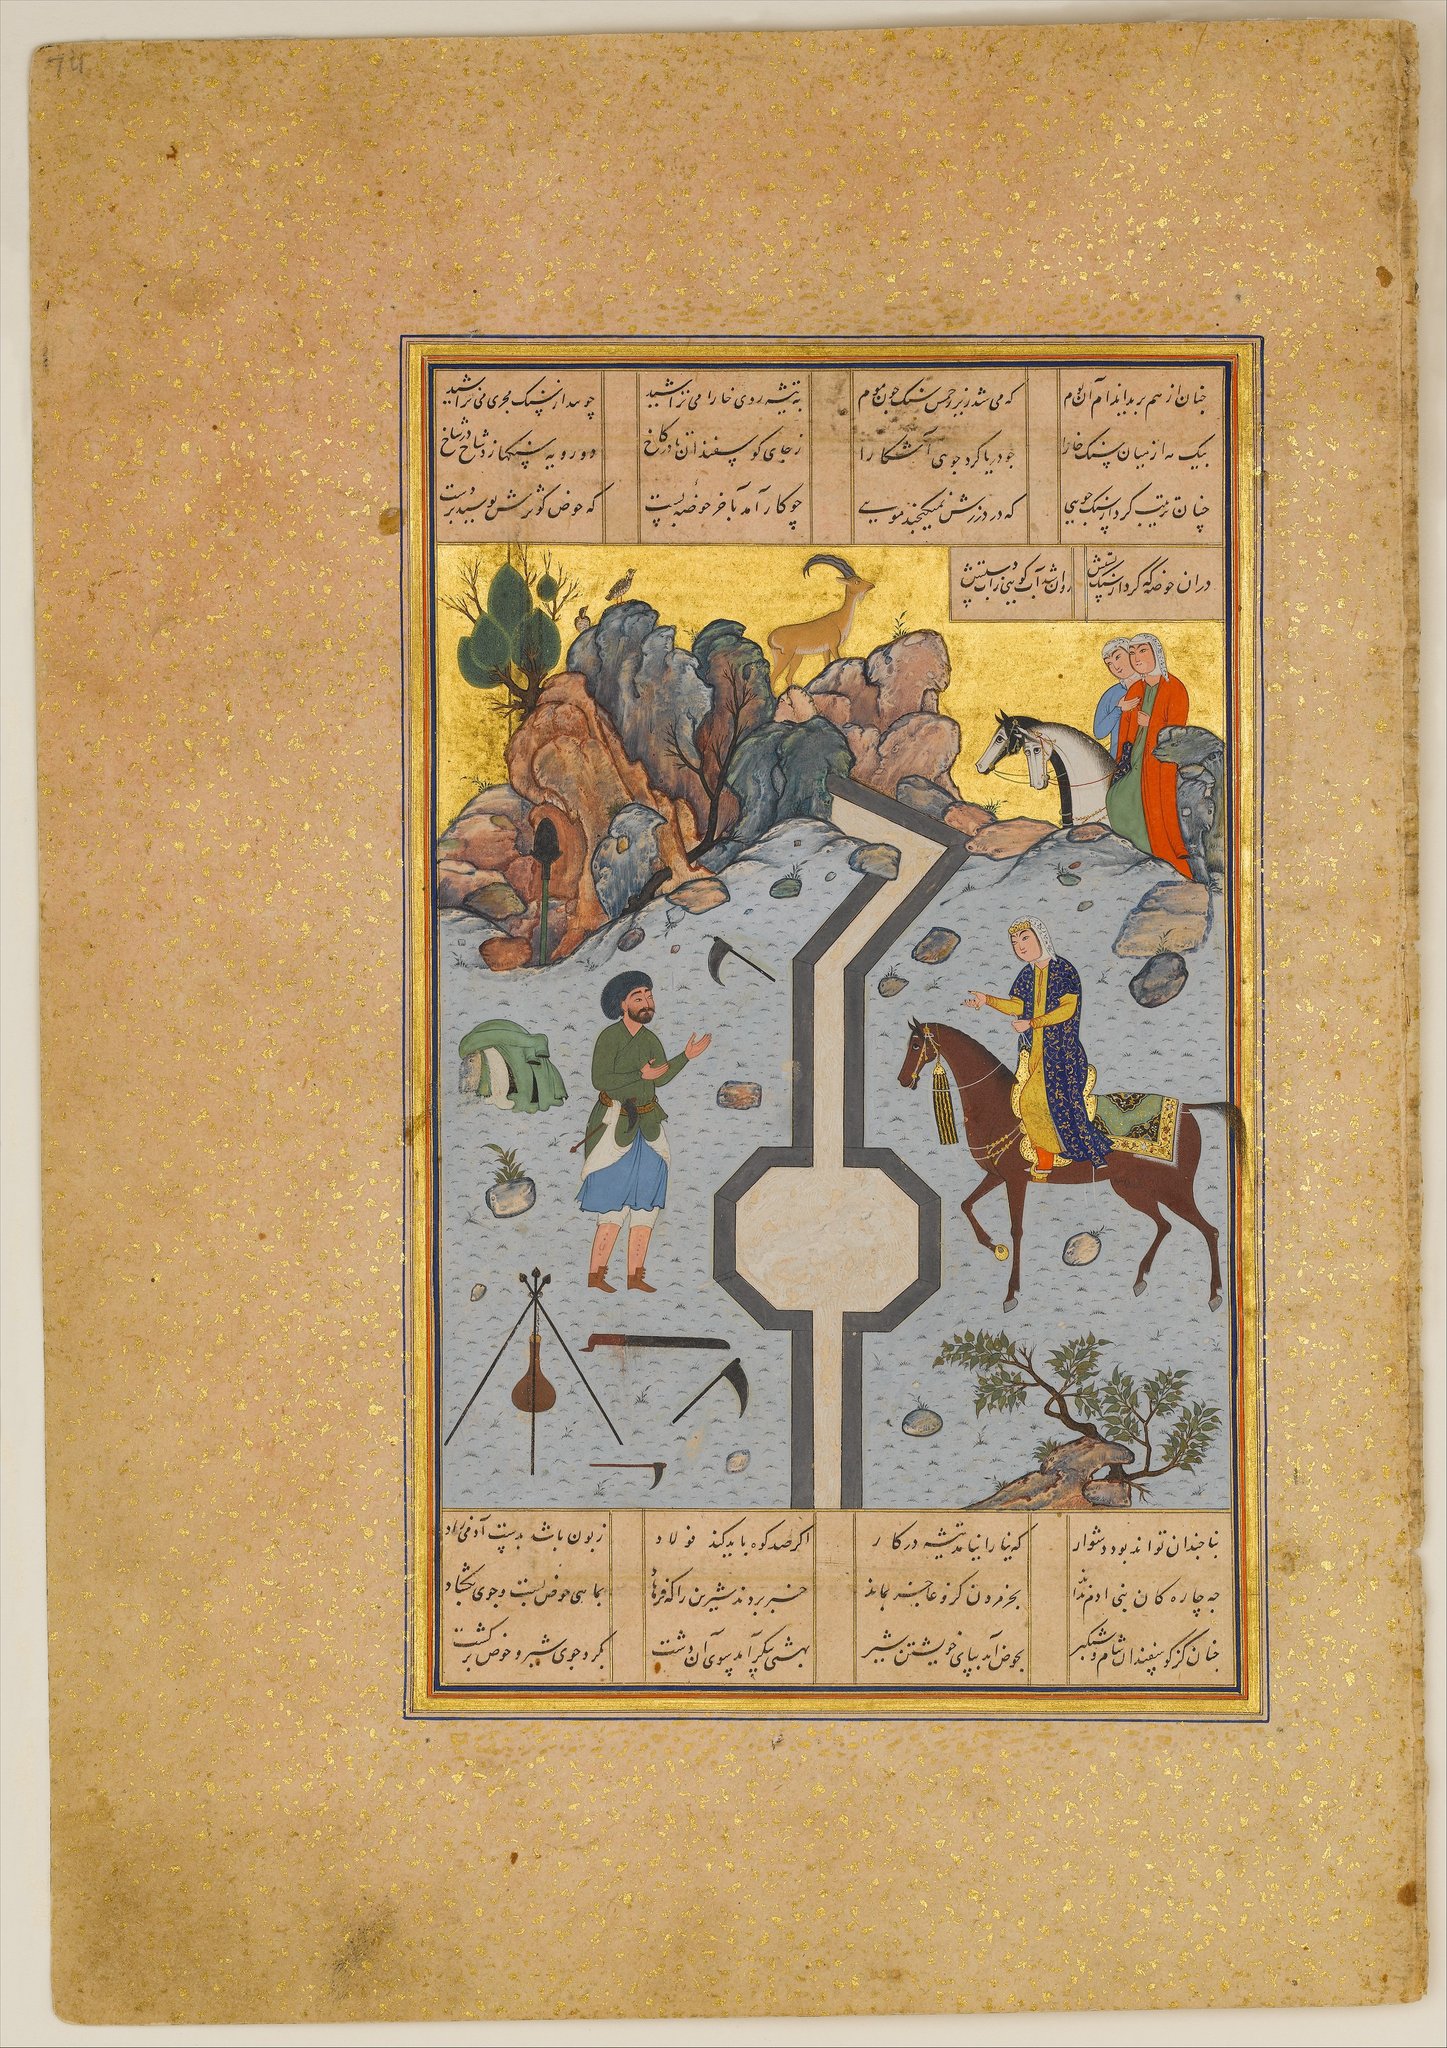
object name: folio from an illustrated manuscript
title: "Farhad Carves a Milk Channel for Shirin", Folio 74 from a Khamsa (Quintet) of Nizami of Ganja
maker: nizami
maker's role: author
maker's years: 1141-1209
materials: gold, ink, paper, watercolor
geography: afghanistan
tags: men,women,goats,horses